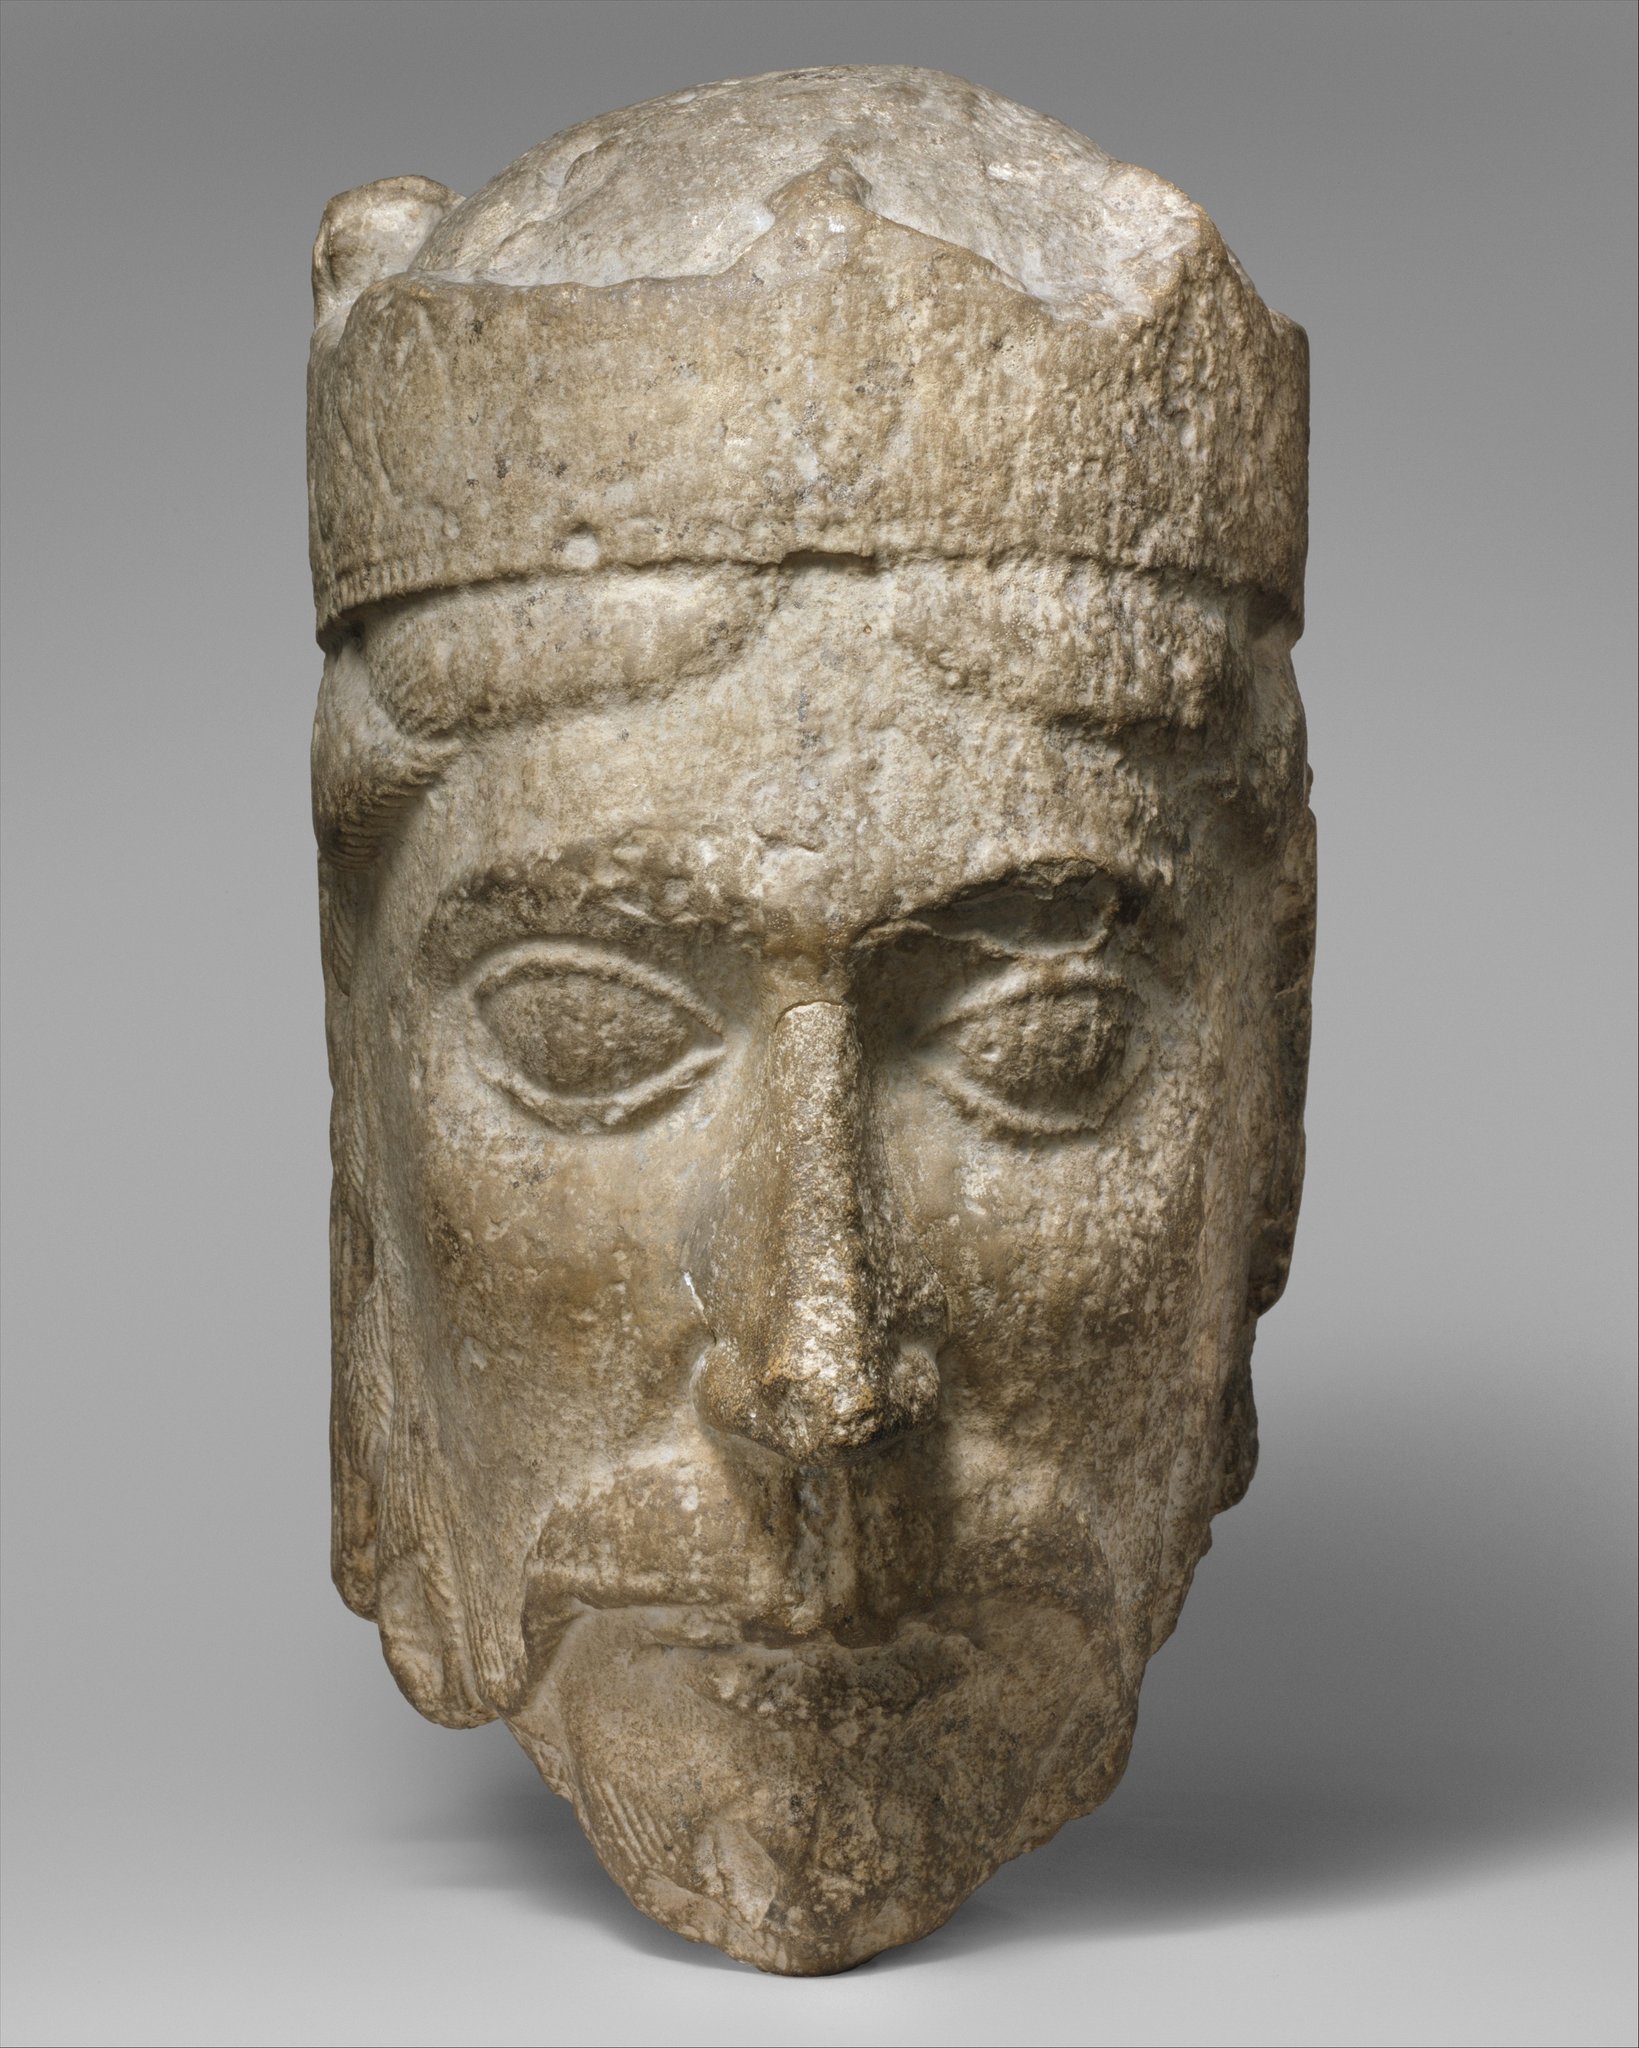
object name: statue head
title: Head of a King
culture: french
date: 1150-1175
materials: limestone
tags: heads